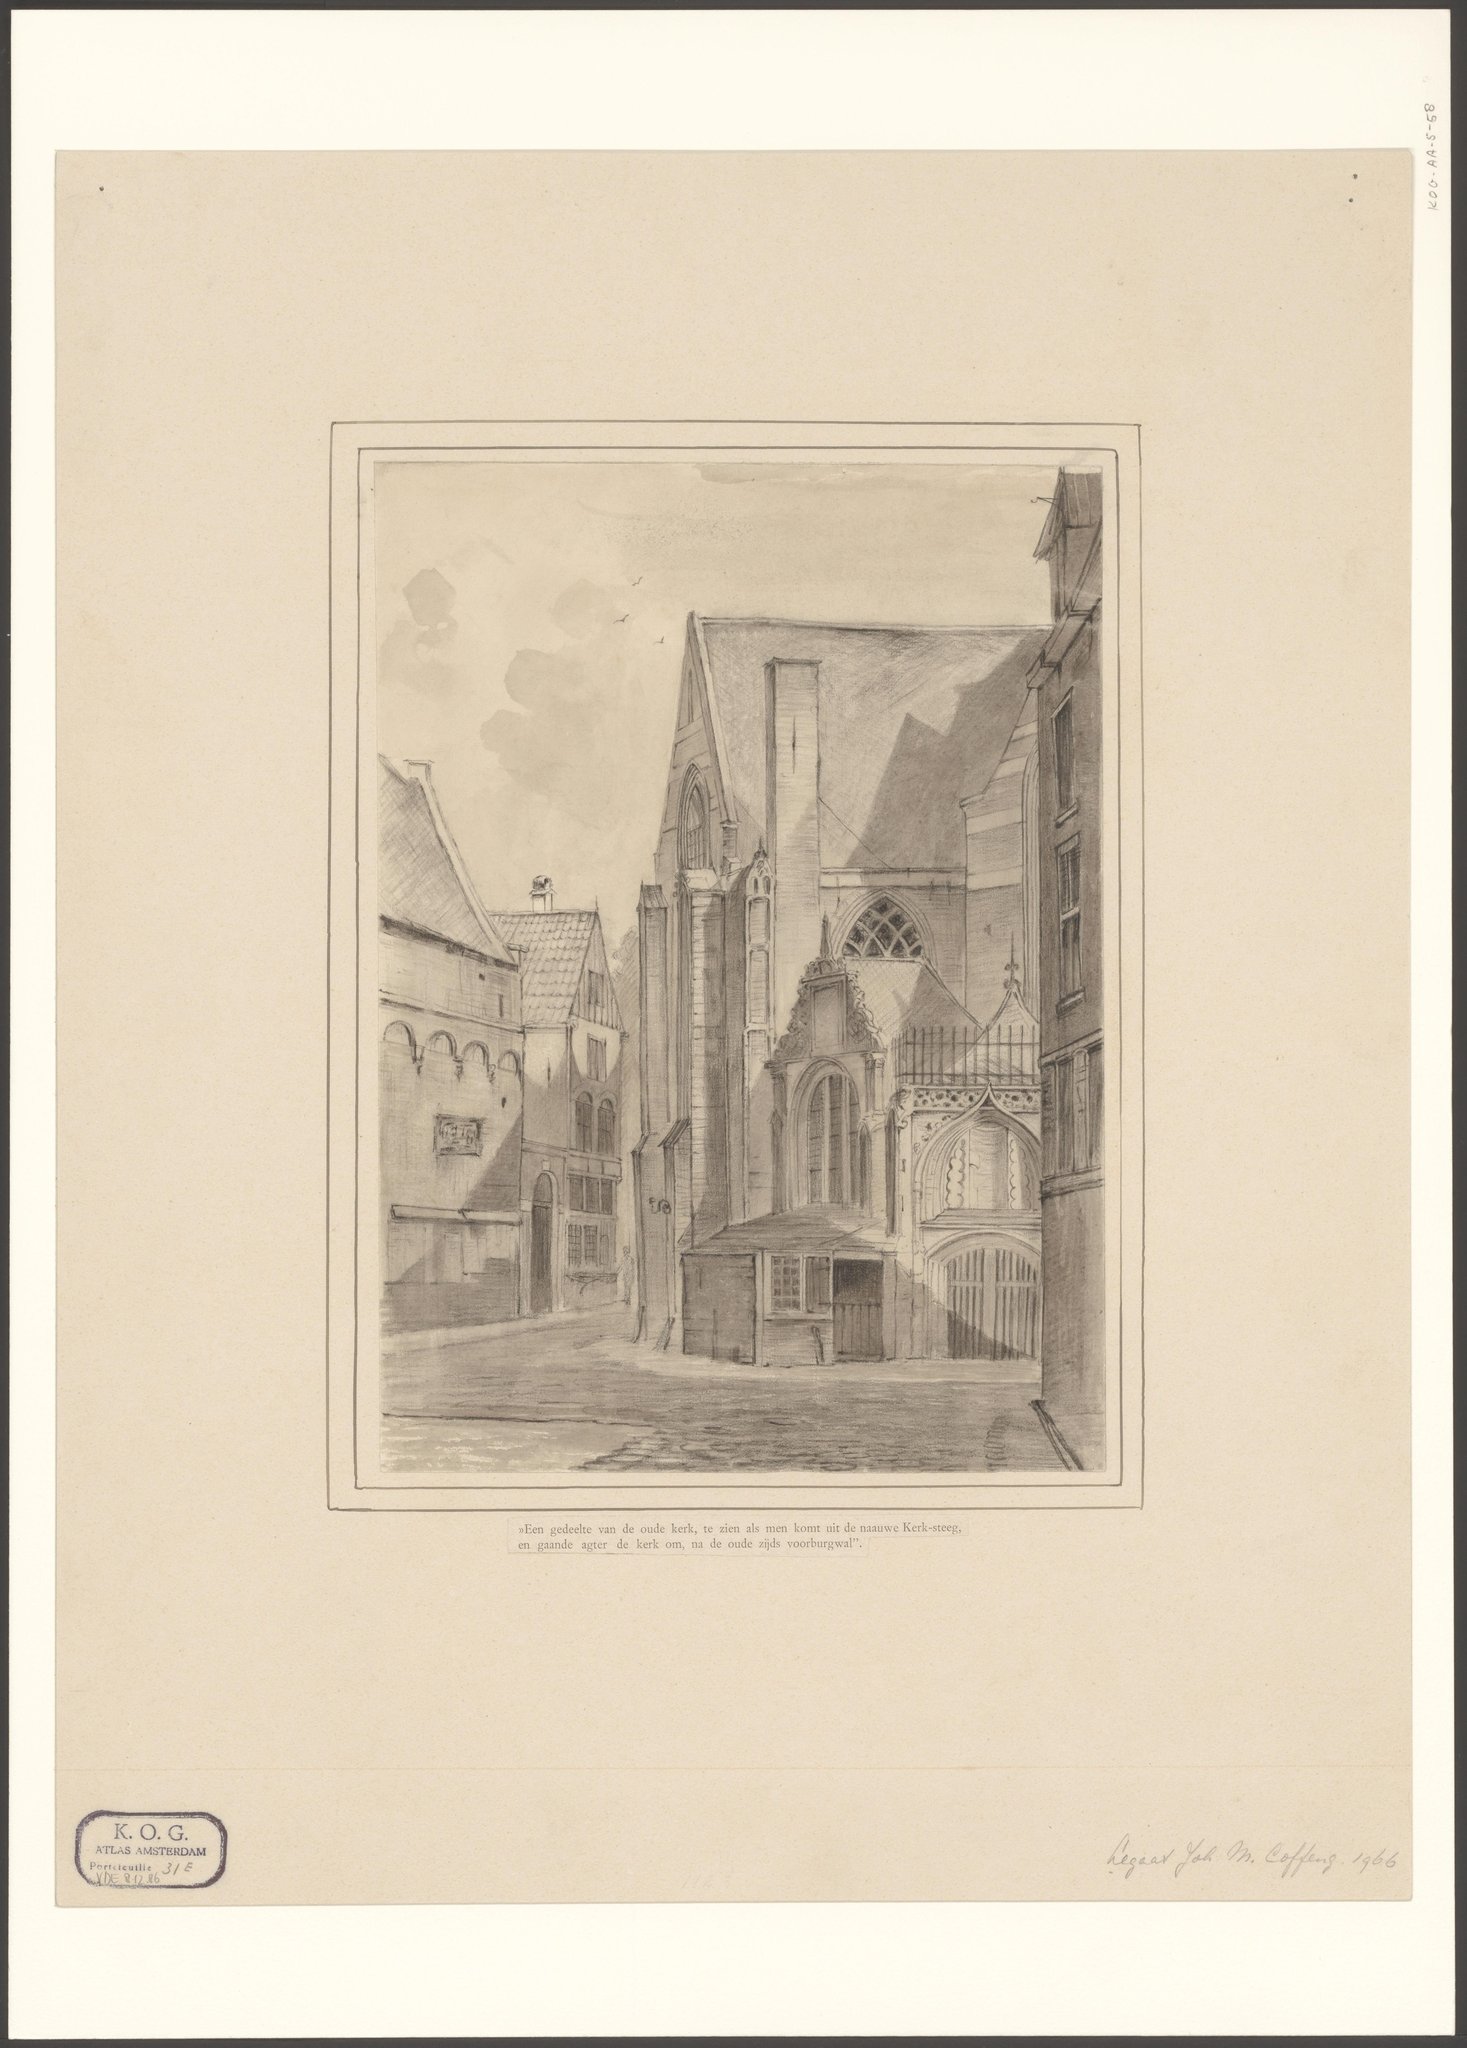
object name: drawing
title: Gezicht op de Oude Kerk vanaf de Enge Kerksteeg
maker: Anonymous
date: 1825-1925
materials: chalk, ink, paper, pencil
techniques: brush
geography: amsterdam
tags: city-view in general; 'veduta', church (exterior), lane, alley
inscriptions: number: ‘44’, inscription: ‘"Een gedeelte van (...) oude zijds voorburgwal".’, inscription: ‘D.-’, collector's mark: ‘31E / VDE 8.12.86’ Lugt 1641b, inscription: ‘Legaat Joh. M. Coffeng.1966’